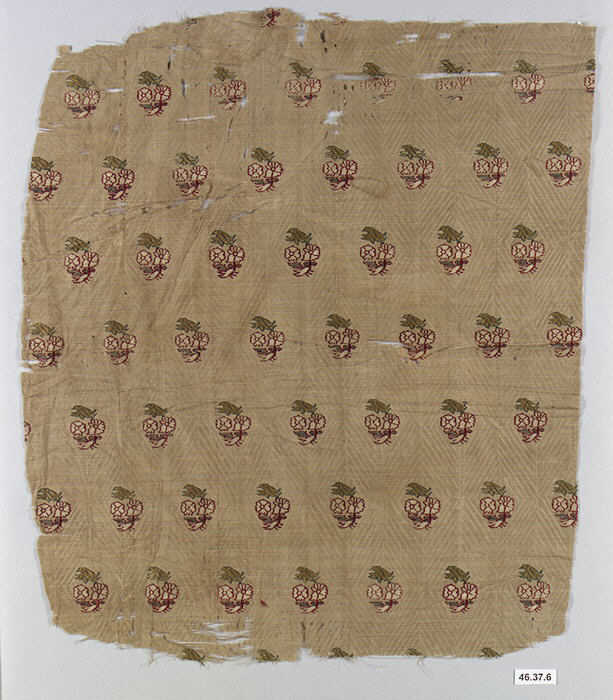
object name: textile fragment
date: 1701-1800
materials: silk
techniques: brocade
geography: india